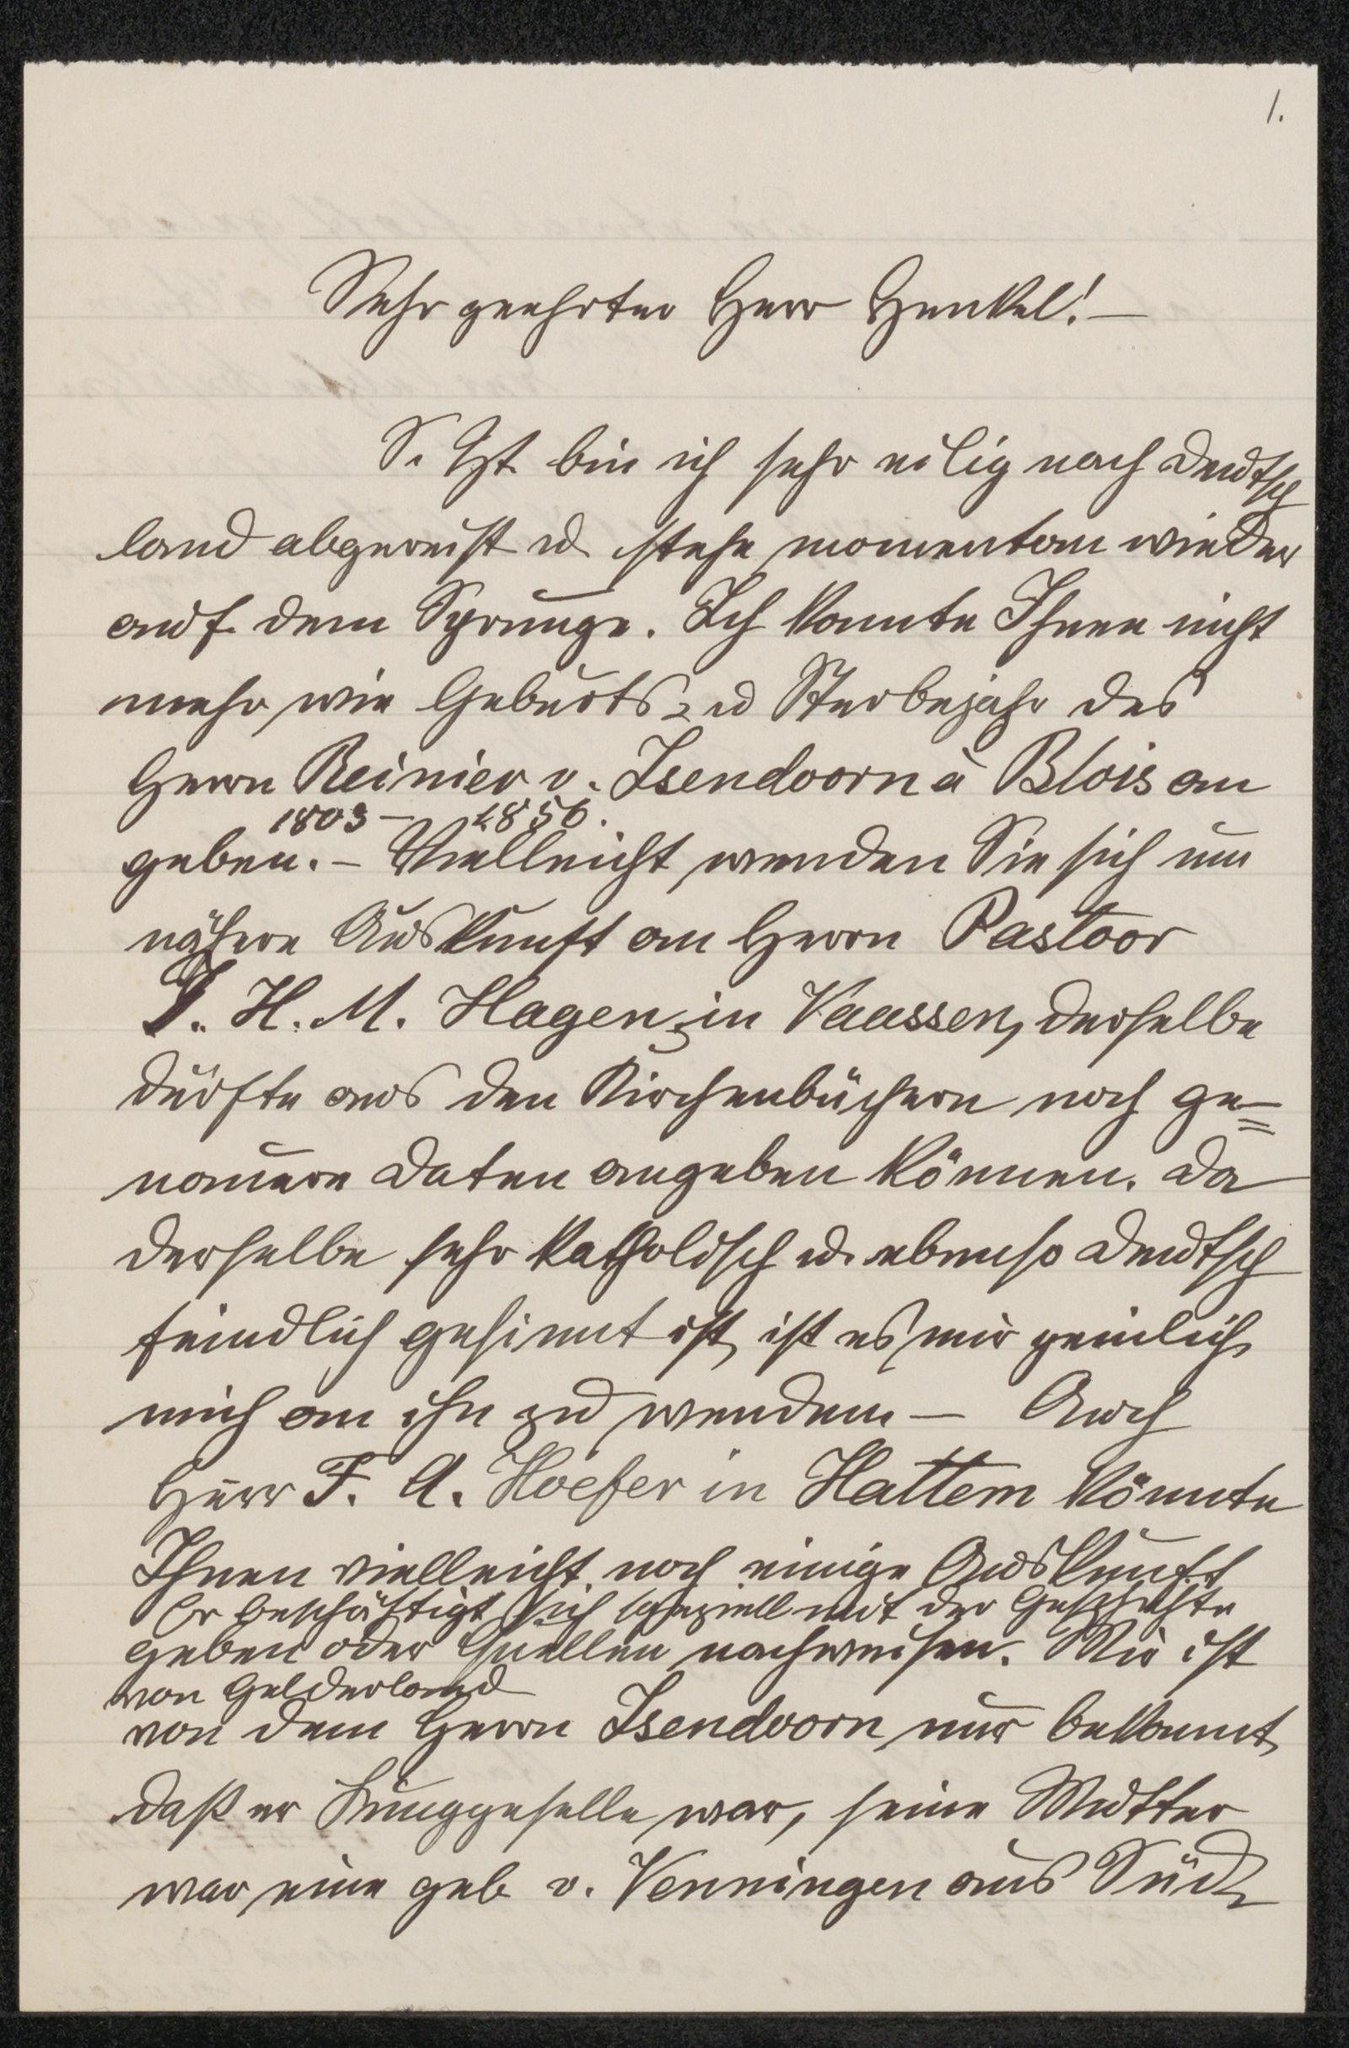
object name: letter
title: Brief aan Max Dittmar Henkel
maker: richard cleve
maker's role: print maker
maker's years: 1860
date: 1925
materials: ink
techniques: pen, writing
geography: vaassen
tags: utrecht, priest, jacobus henricus maria hagen, reinierus albertus ludovicus baron van isendoorn à blois, max dittmar henkel, zeist